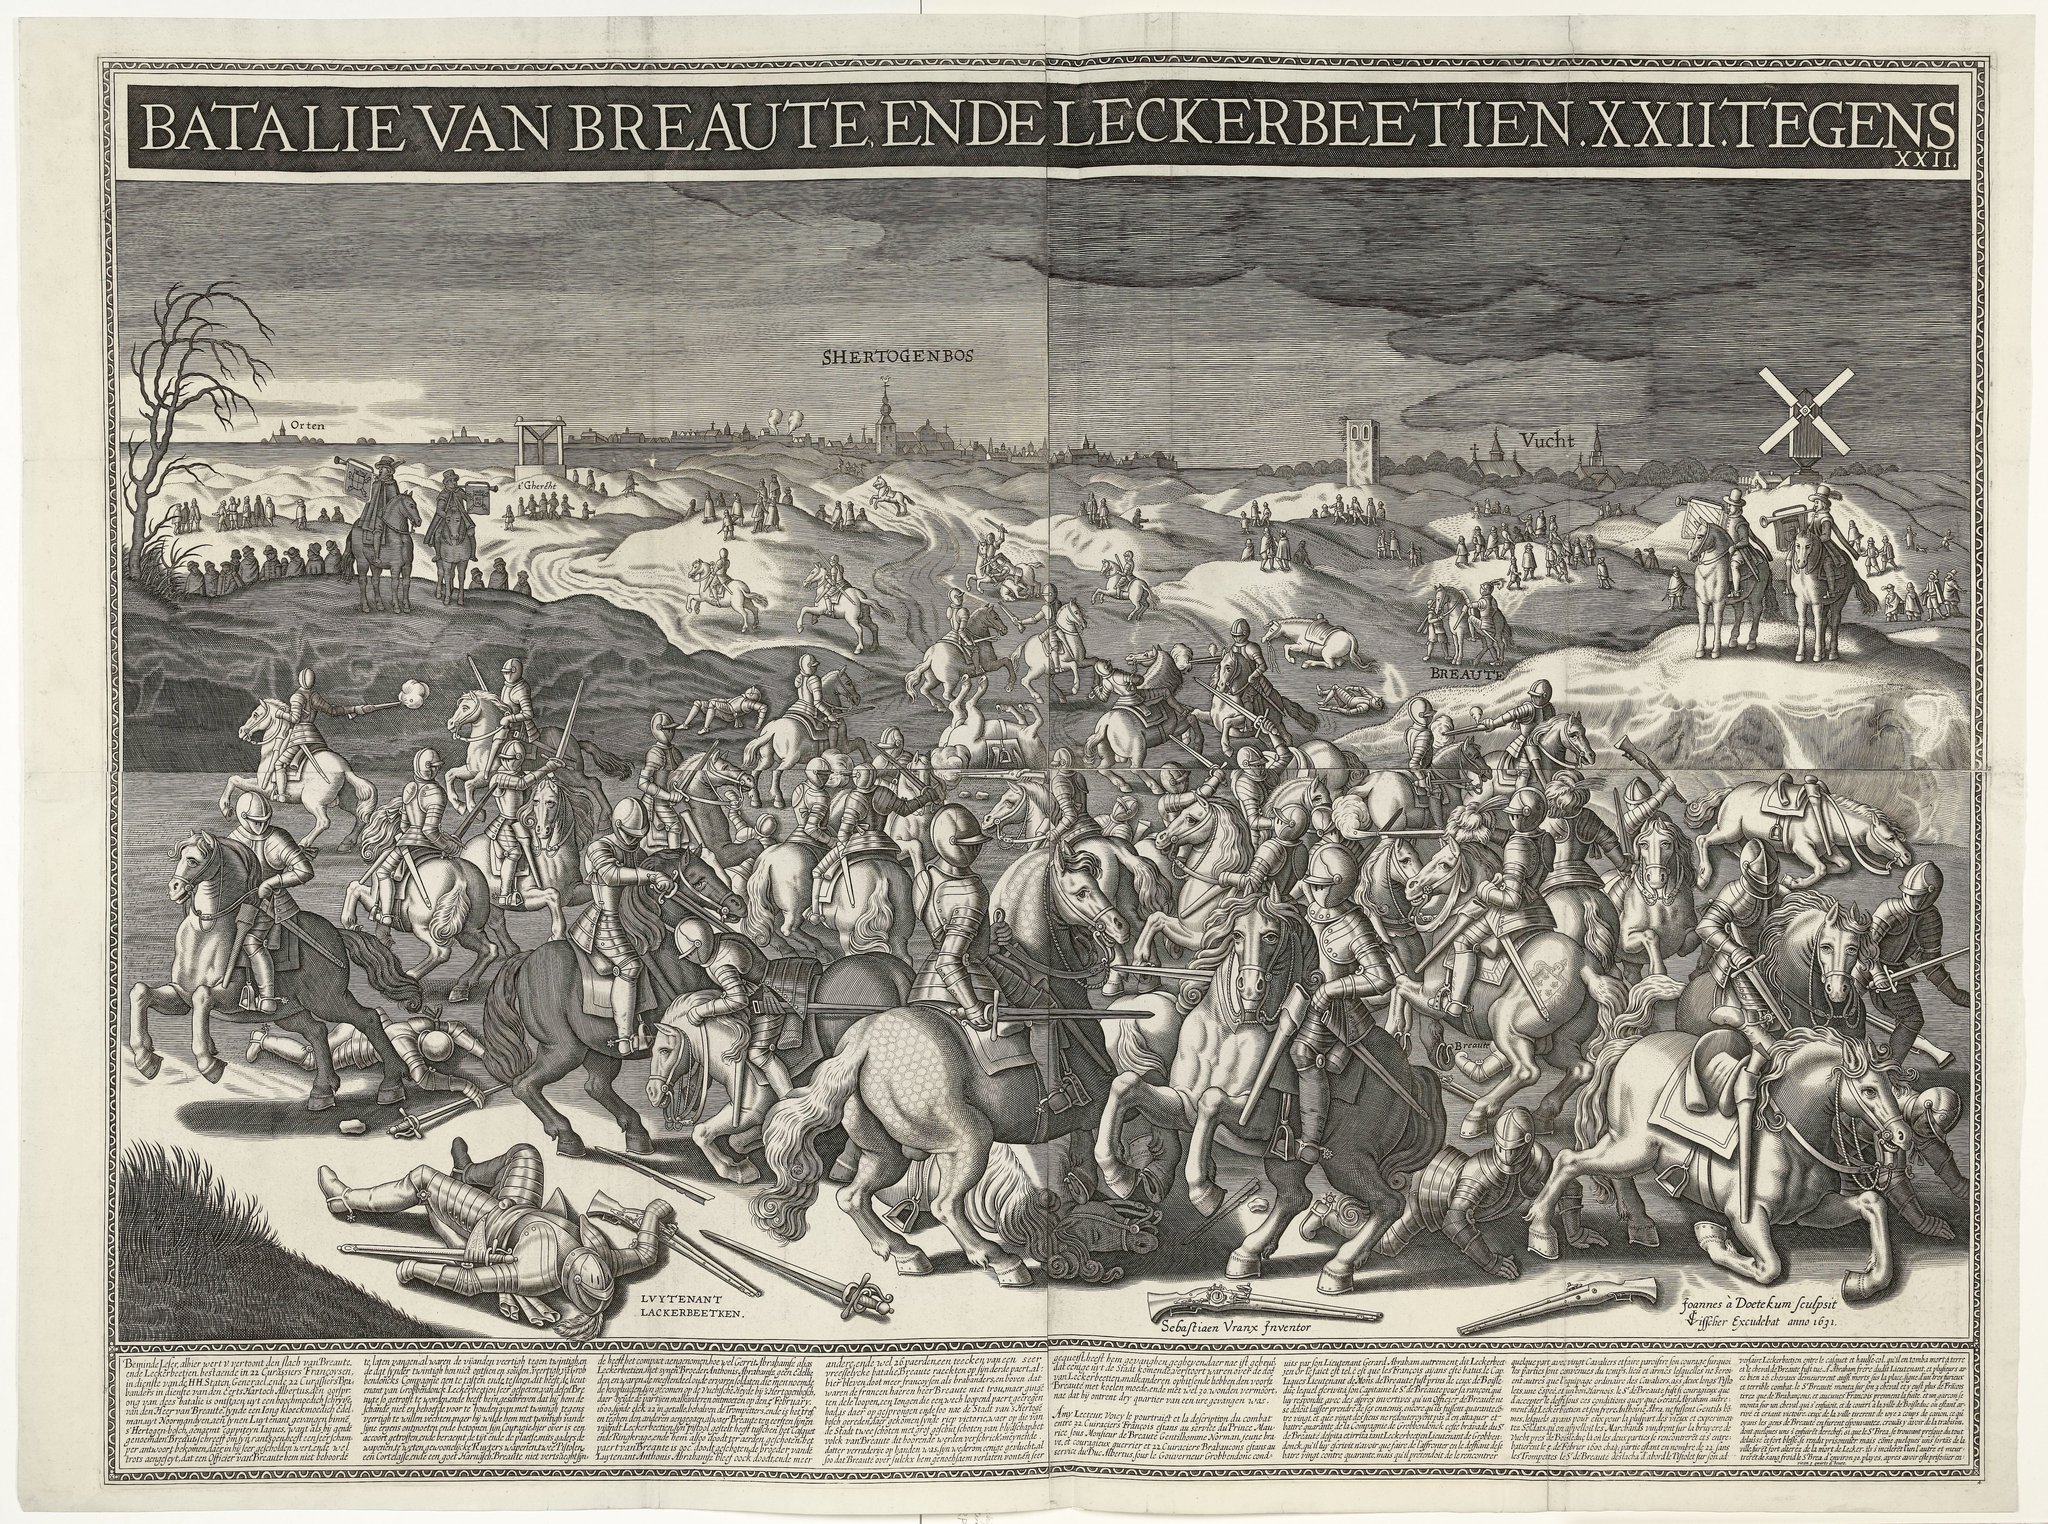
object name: history print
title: Batalie van Breaute, ende Leckerbeetien. XXII tegens XXII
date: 1600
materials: paper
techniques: engraving, etching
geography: northern netherlands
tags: battle (+ land forces), den bosch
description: De slag van Lekkerbeetje, 5 februari 1600. Veldslag tussen de ruiters van de heer van Breauté, een Fransman in dienst van de Staten en Gerrit Abrahamsz., alias Leckerbeetje, Luitenant van Spanje in 's-Hertogenbosch, op de Vughterheide bij Den Bosch, met 21 ruiters. Op de achtergrond links de stad Den Bosch,; rechts Vught en een molen. Op de voorgrond het lijk van Lekkerbeetje. Onder de voorstelling een uitvoerig verhaal van het gevecht in het Hollands en in het Frans, in 8 kolommen. Bovenaan zwarte rand waarin de titel.